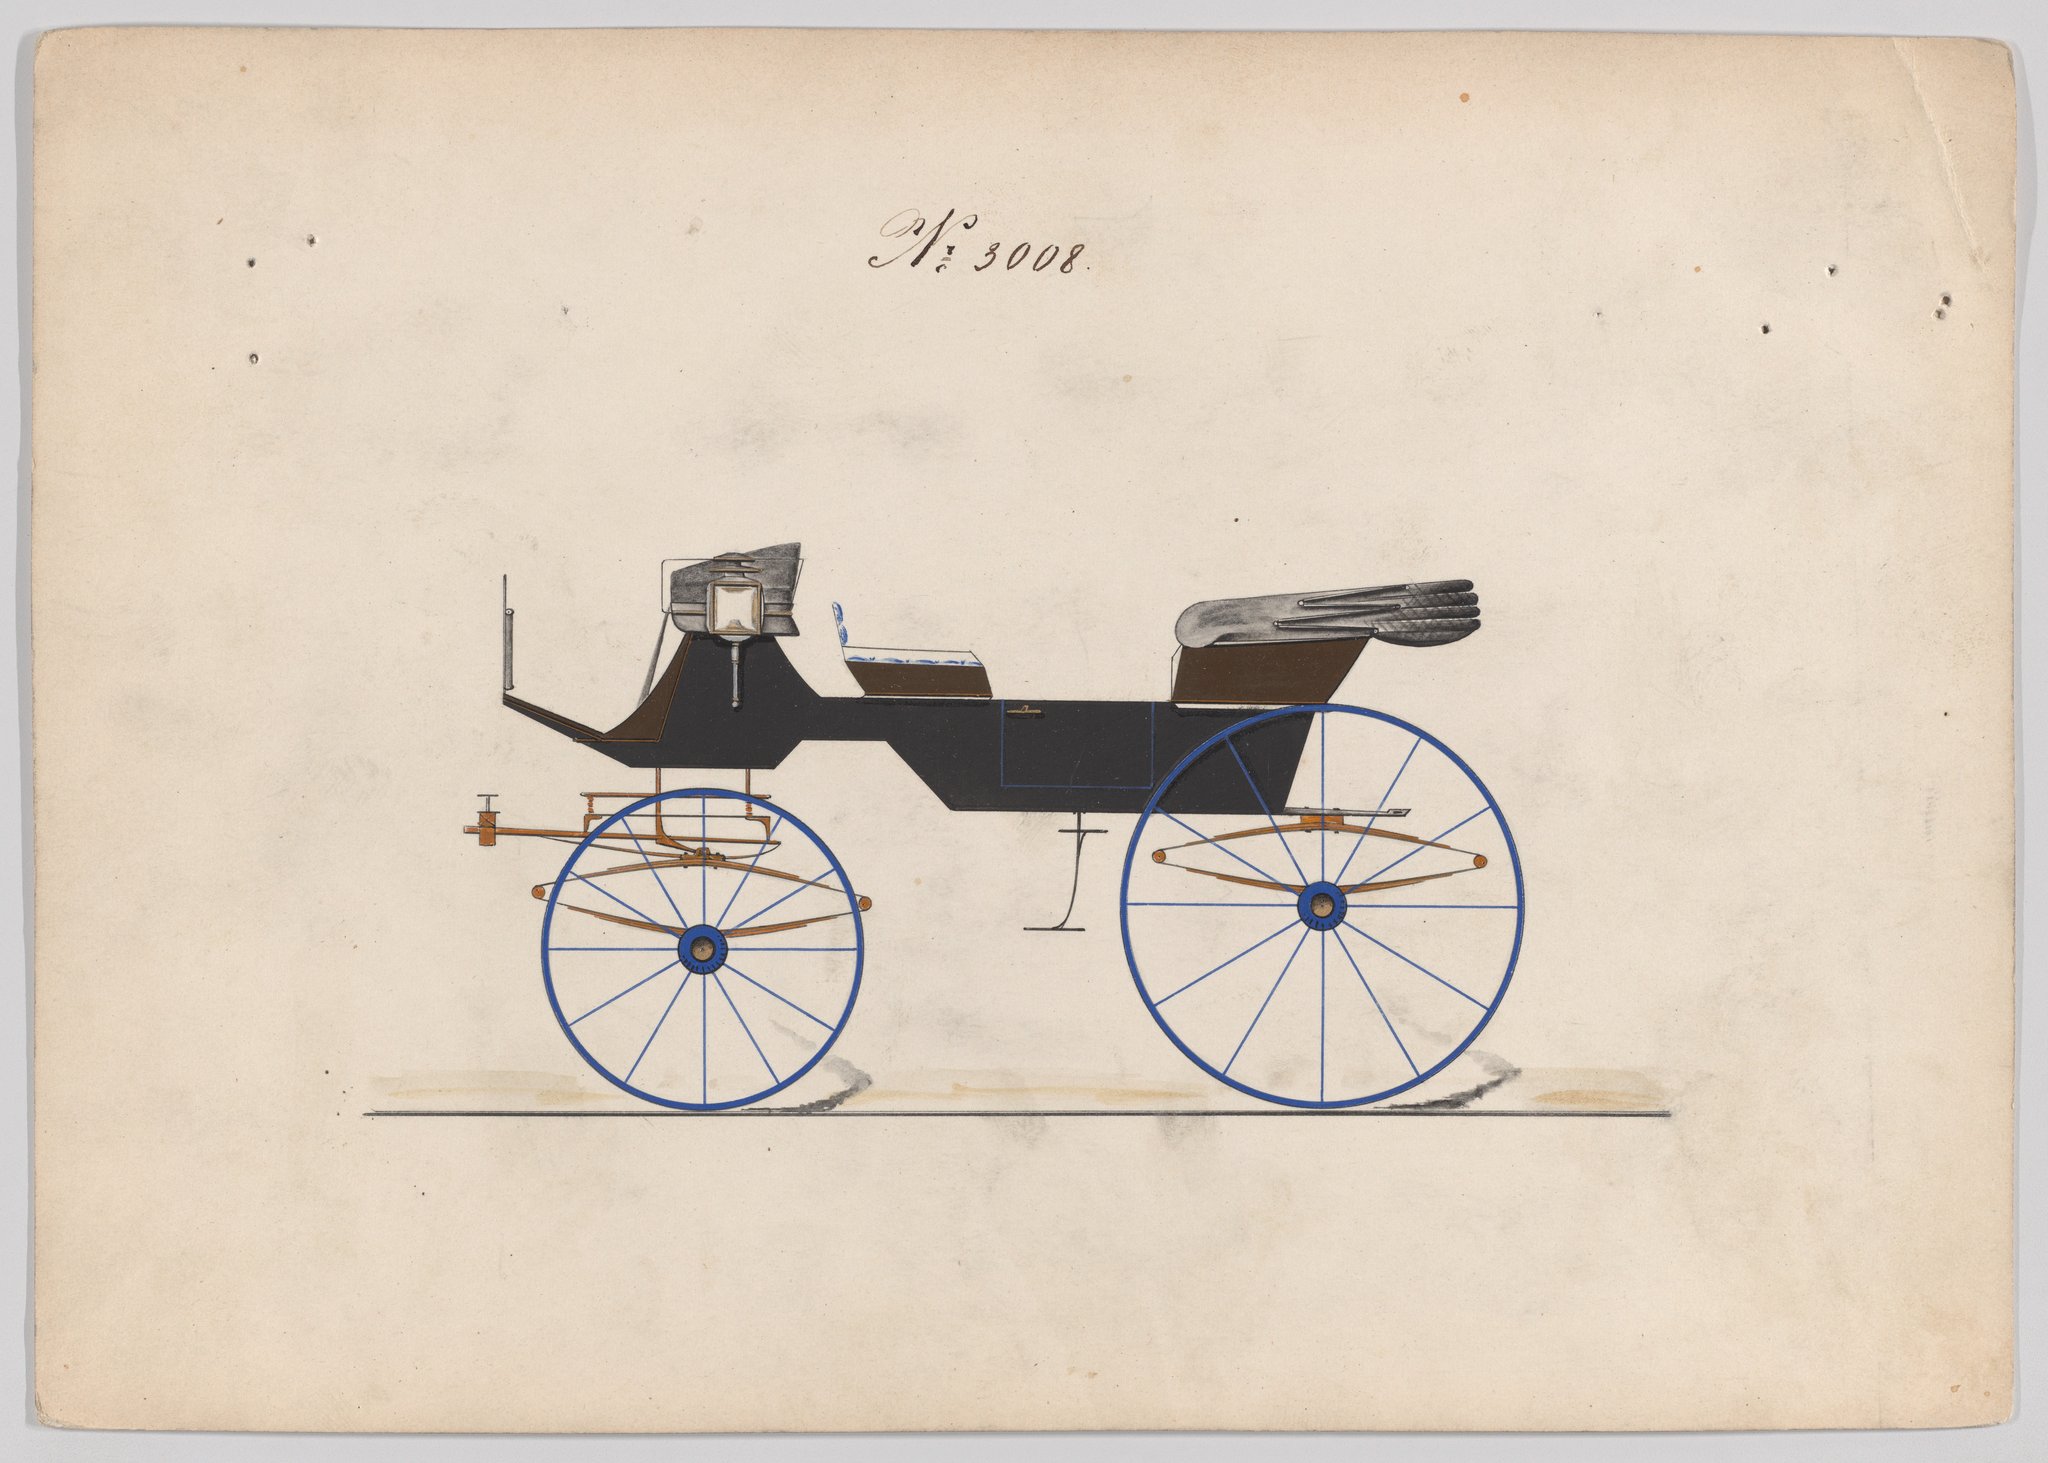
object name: drawing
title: Phaeton #3008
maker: brewster & co.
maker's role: manufacturer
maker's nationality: american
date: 1874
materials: gouache, gum arabic, ink, watercolor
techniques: pen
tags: carriages